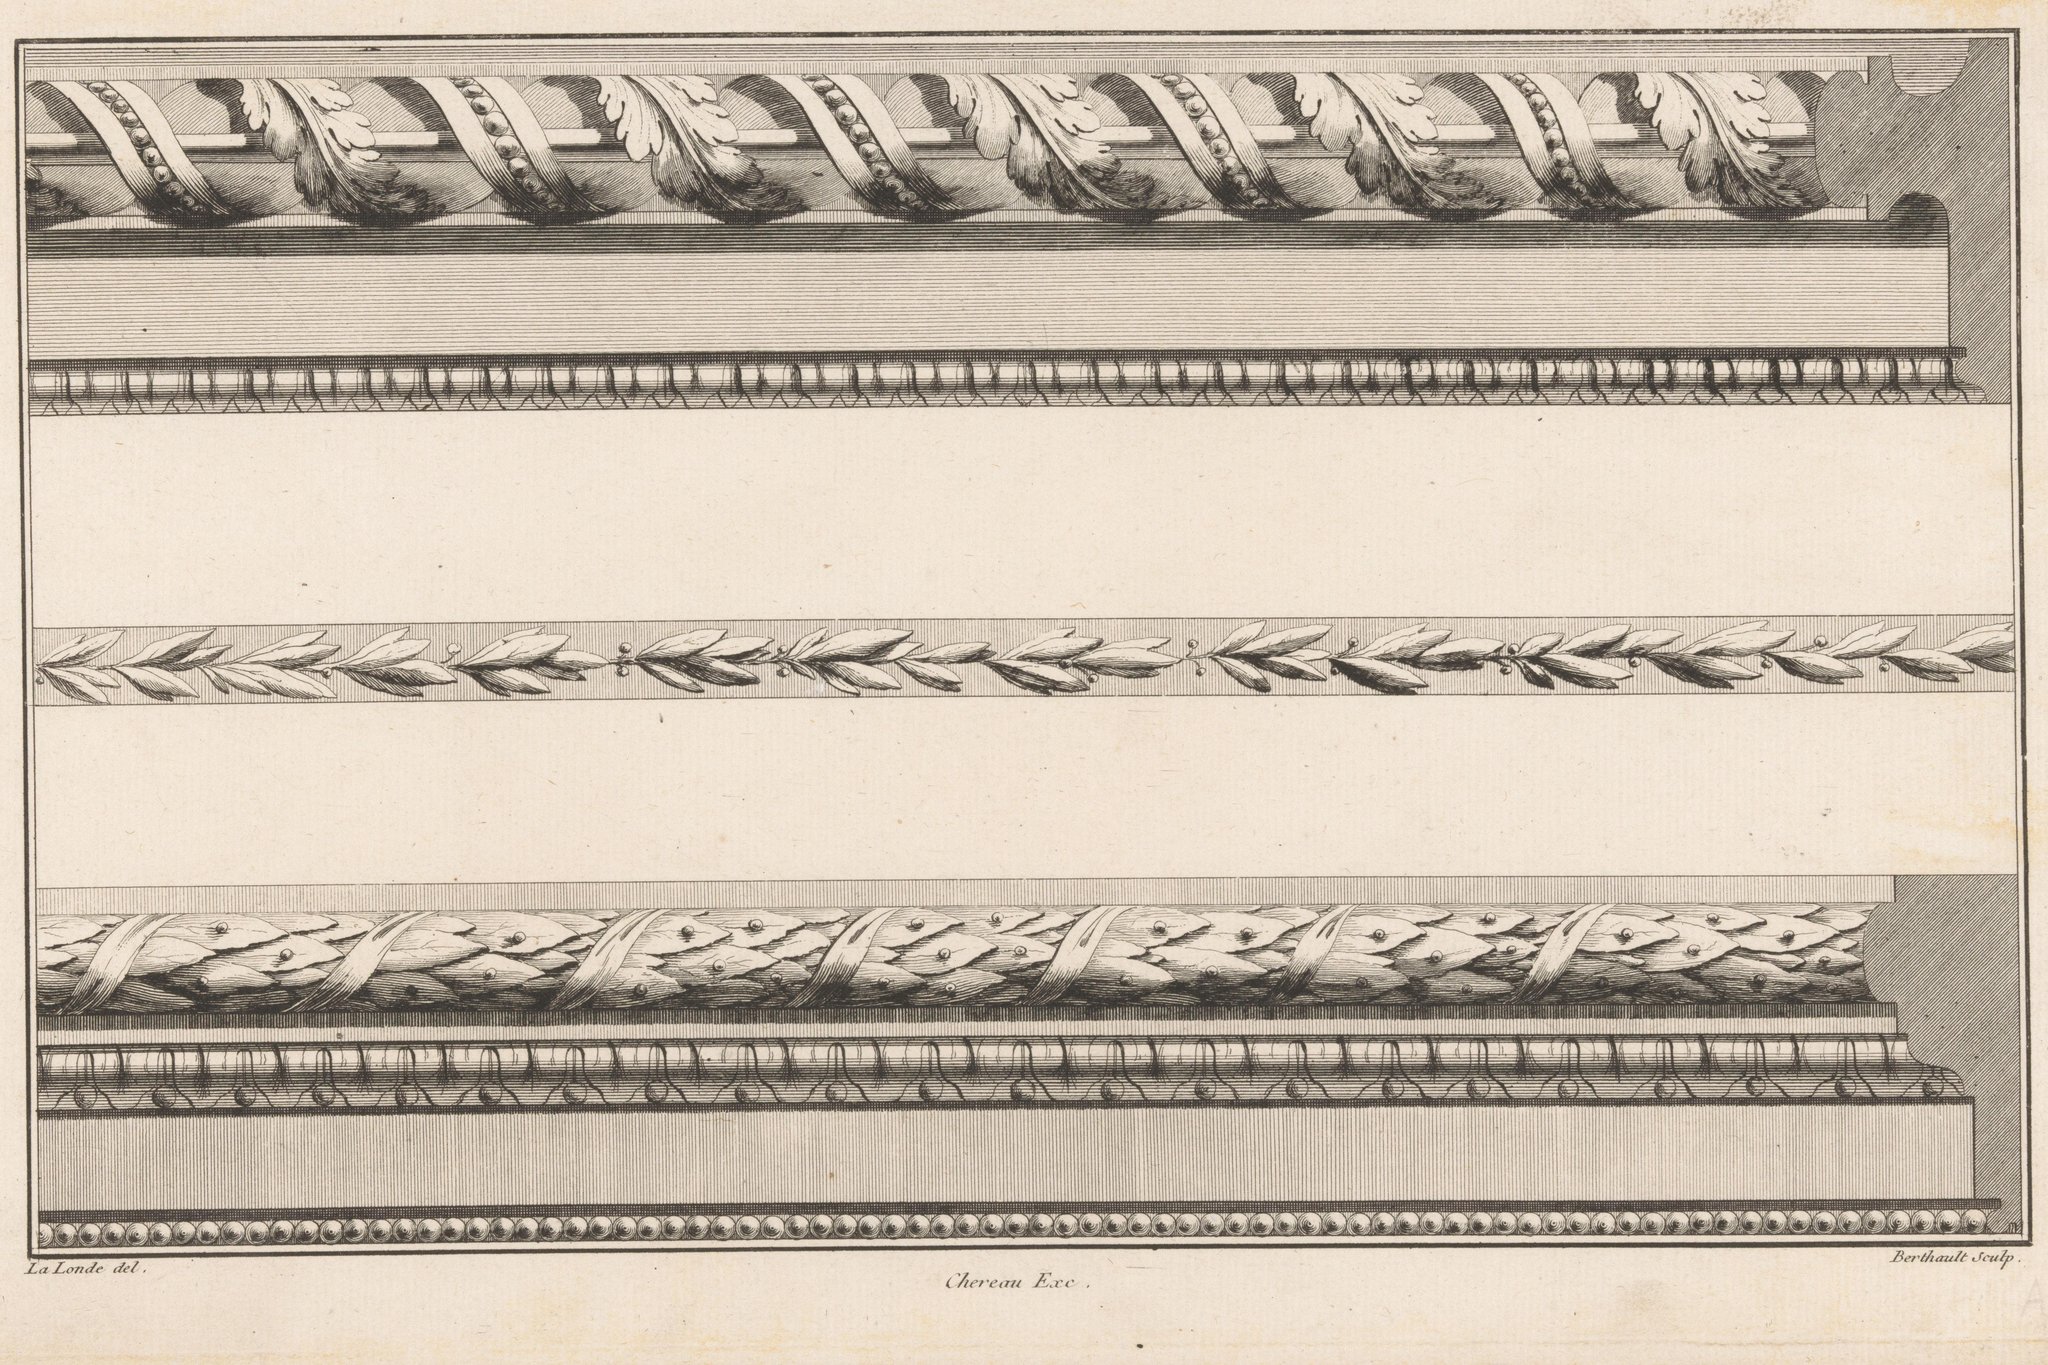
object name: ornament print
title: Drie lijsten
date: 1784-1785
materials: paper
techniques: engraving, etching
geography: paris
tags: ornaments ~ art (+ framing decorations)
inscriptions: collector's mark: Lugt 2760, collector's mark: Lugt 2228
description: Een lijst met acanthusbladeren in spiraalvorm en twee lijsten met bladmotieven.